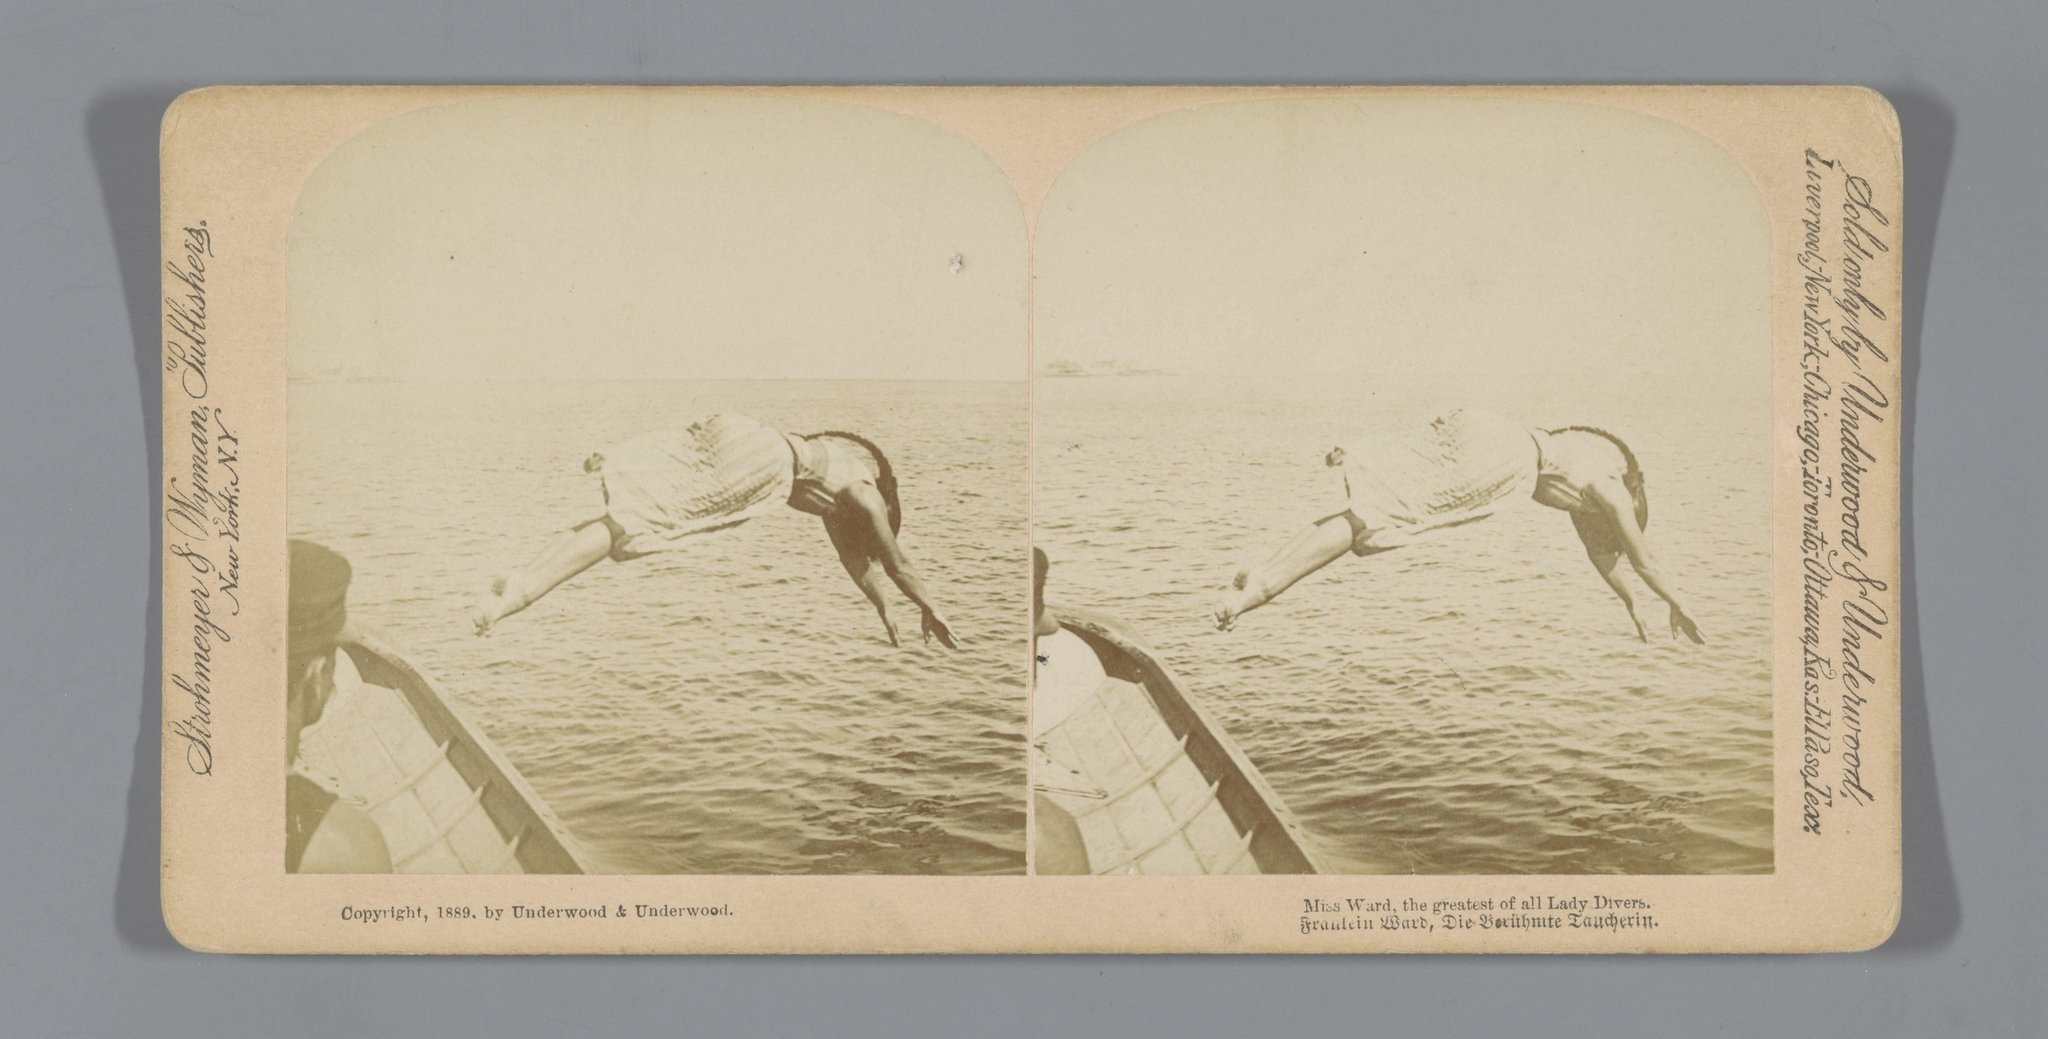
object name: stereograph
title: Vrouw gekleed in jurk duikt vanaf boot in het water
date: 1889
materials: cardboard, photographic support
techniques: albumen print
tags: diving (movement in water)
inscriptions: : ‘Copyright, 1889, by Underwood & Underwood’, company name: ‘Strohmeyer & Wyman Publishers / New York, NY’, company name: ‘Sold only by Underwood & Underwood / Liverpool, New York, Chicago, Toronto, Ottawa, Kas. El Paso, Tex.’